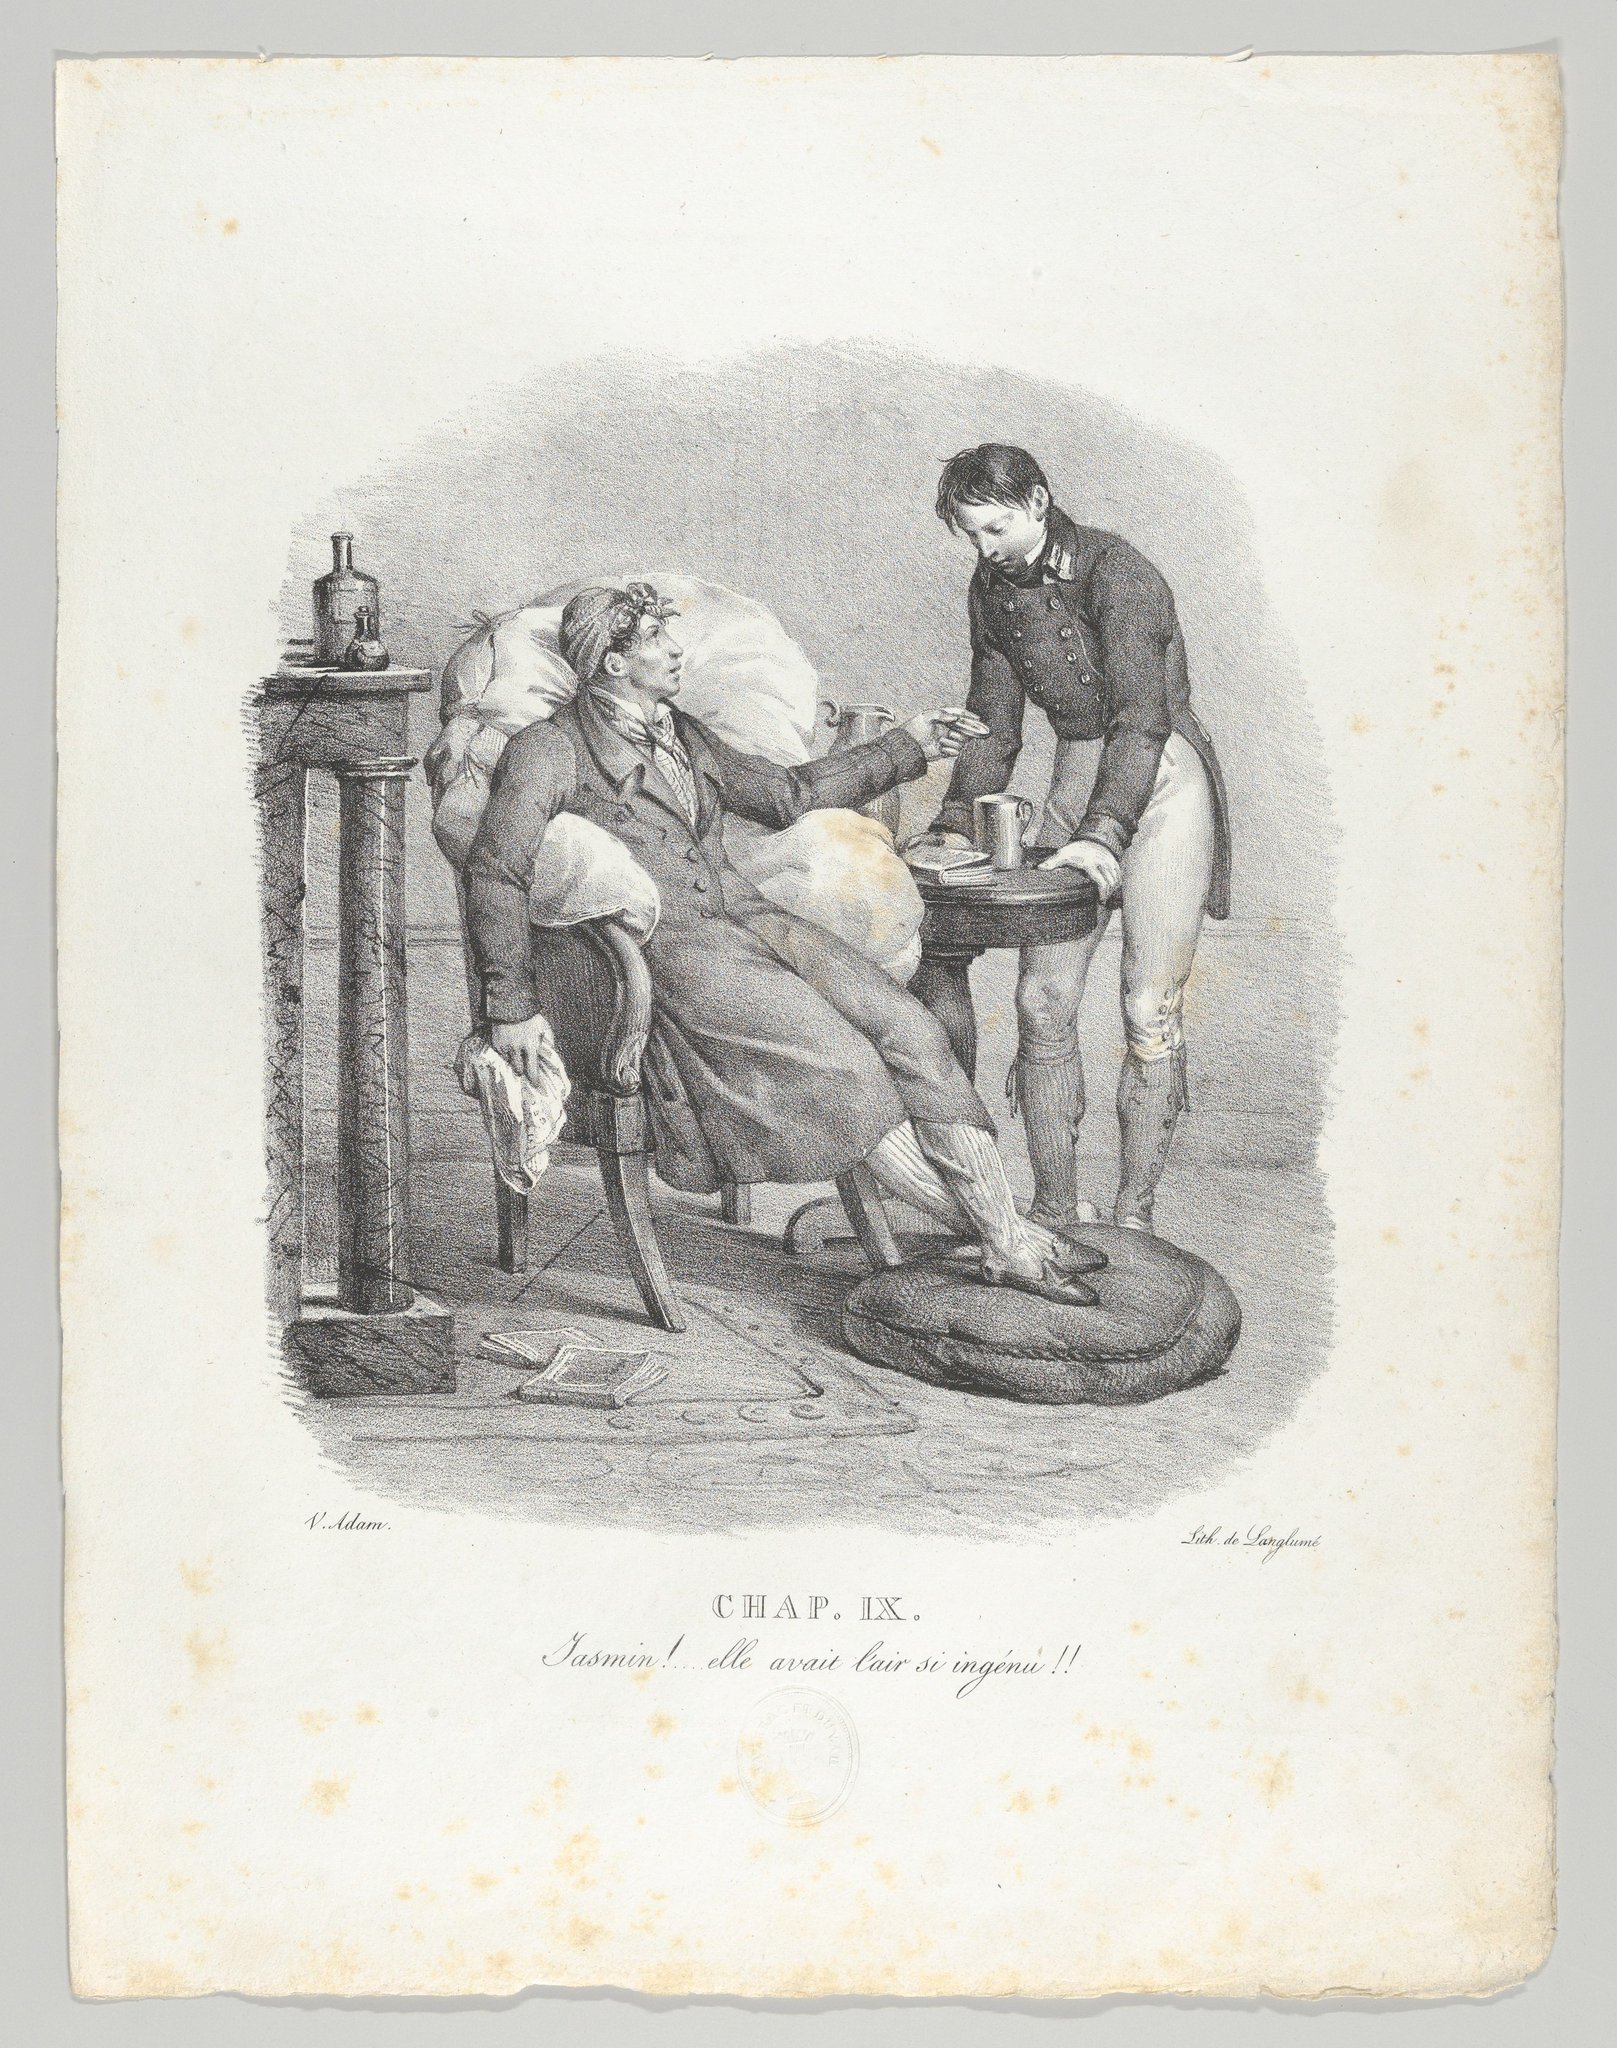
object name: print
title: Chap. IX: Jasmin!...elle avait l'air si ingénu!! (Jasmine gave the impression of being an ingenue!)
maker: victor adam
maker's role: artist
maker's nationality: french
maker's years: 1801-1866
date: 1824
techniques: lithograph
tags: women